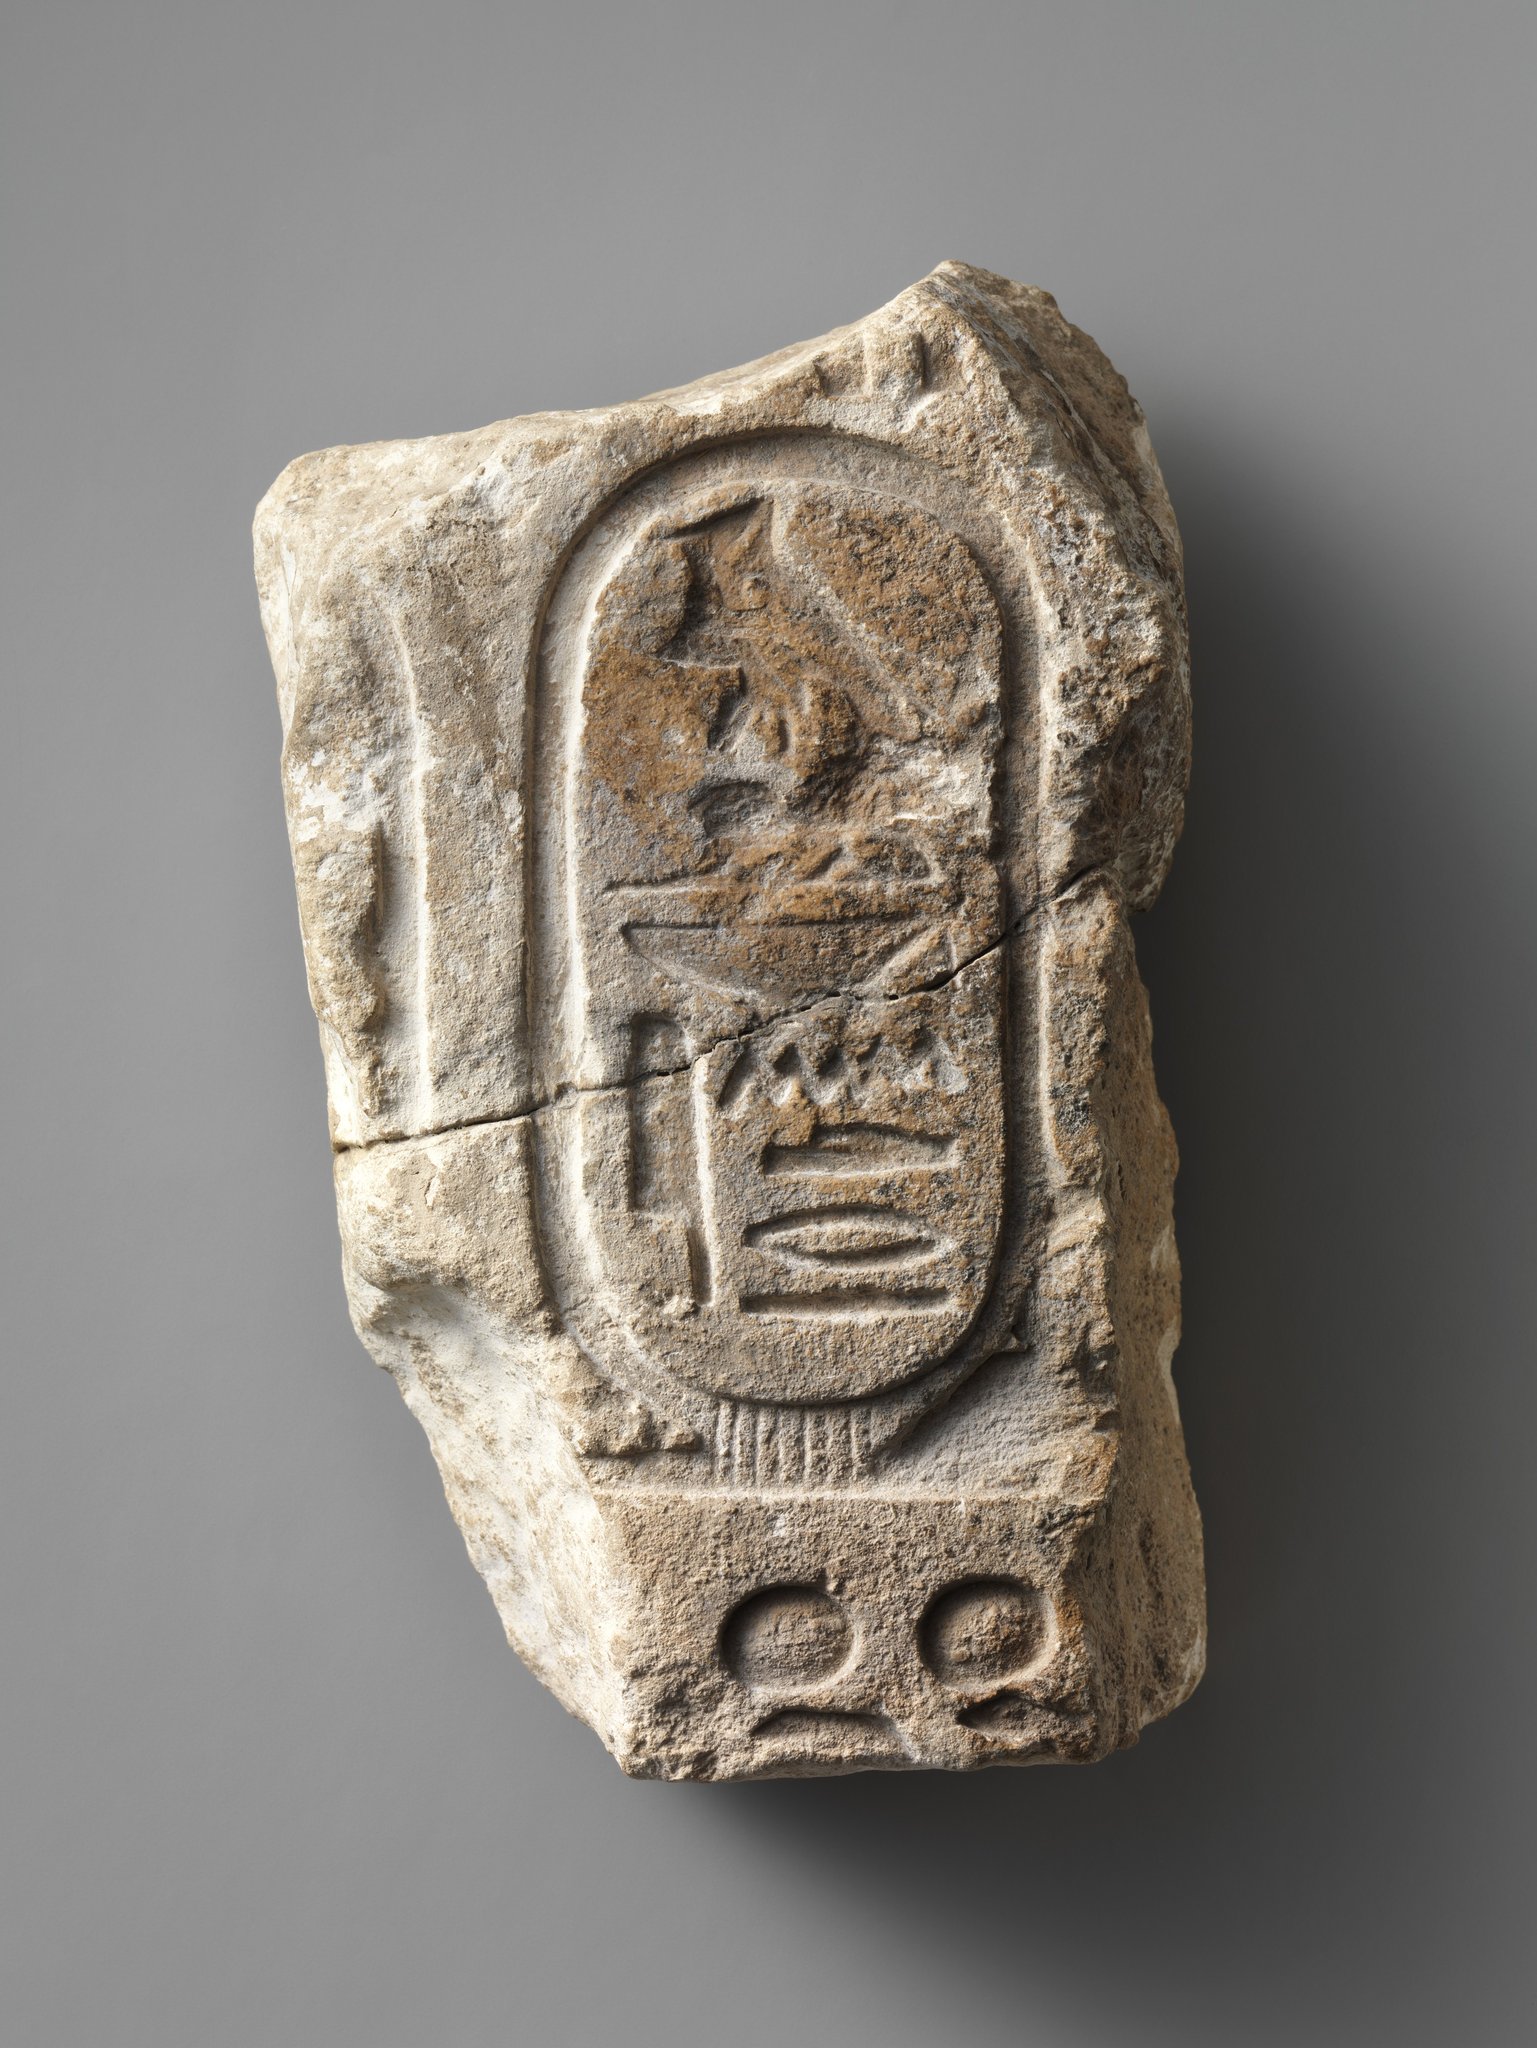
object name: block, cartouche of alexander or his son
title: Block with cartouche of Alexander the Great or his son Alexander IV of Macedon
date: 332-305 BCE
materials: limestone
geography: egypt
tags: cartouches,hieroglyphs